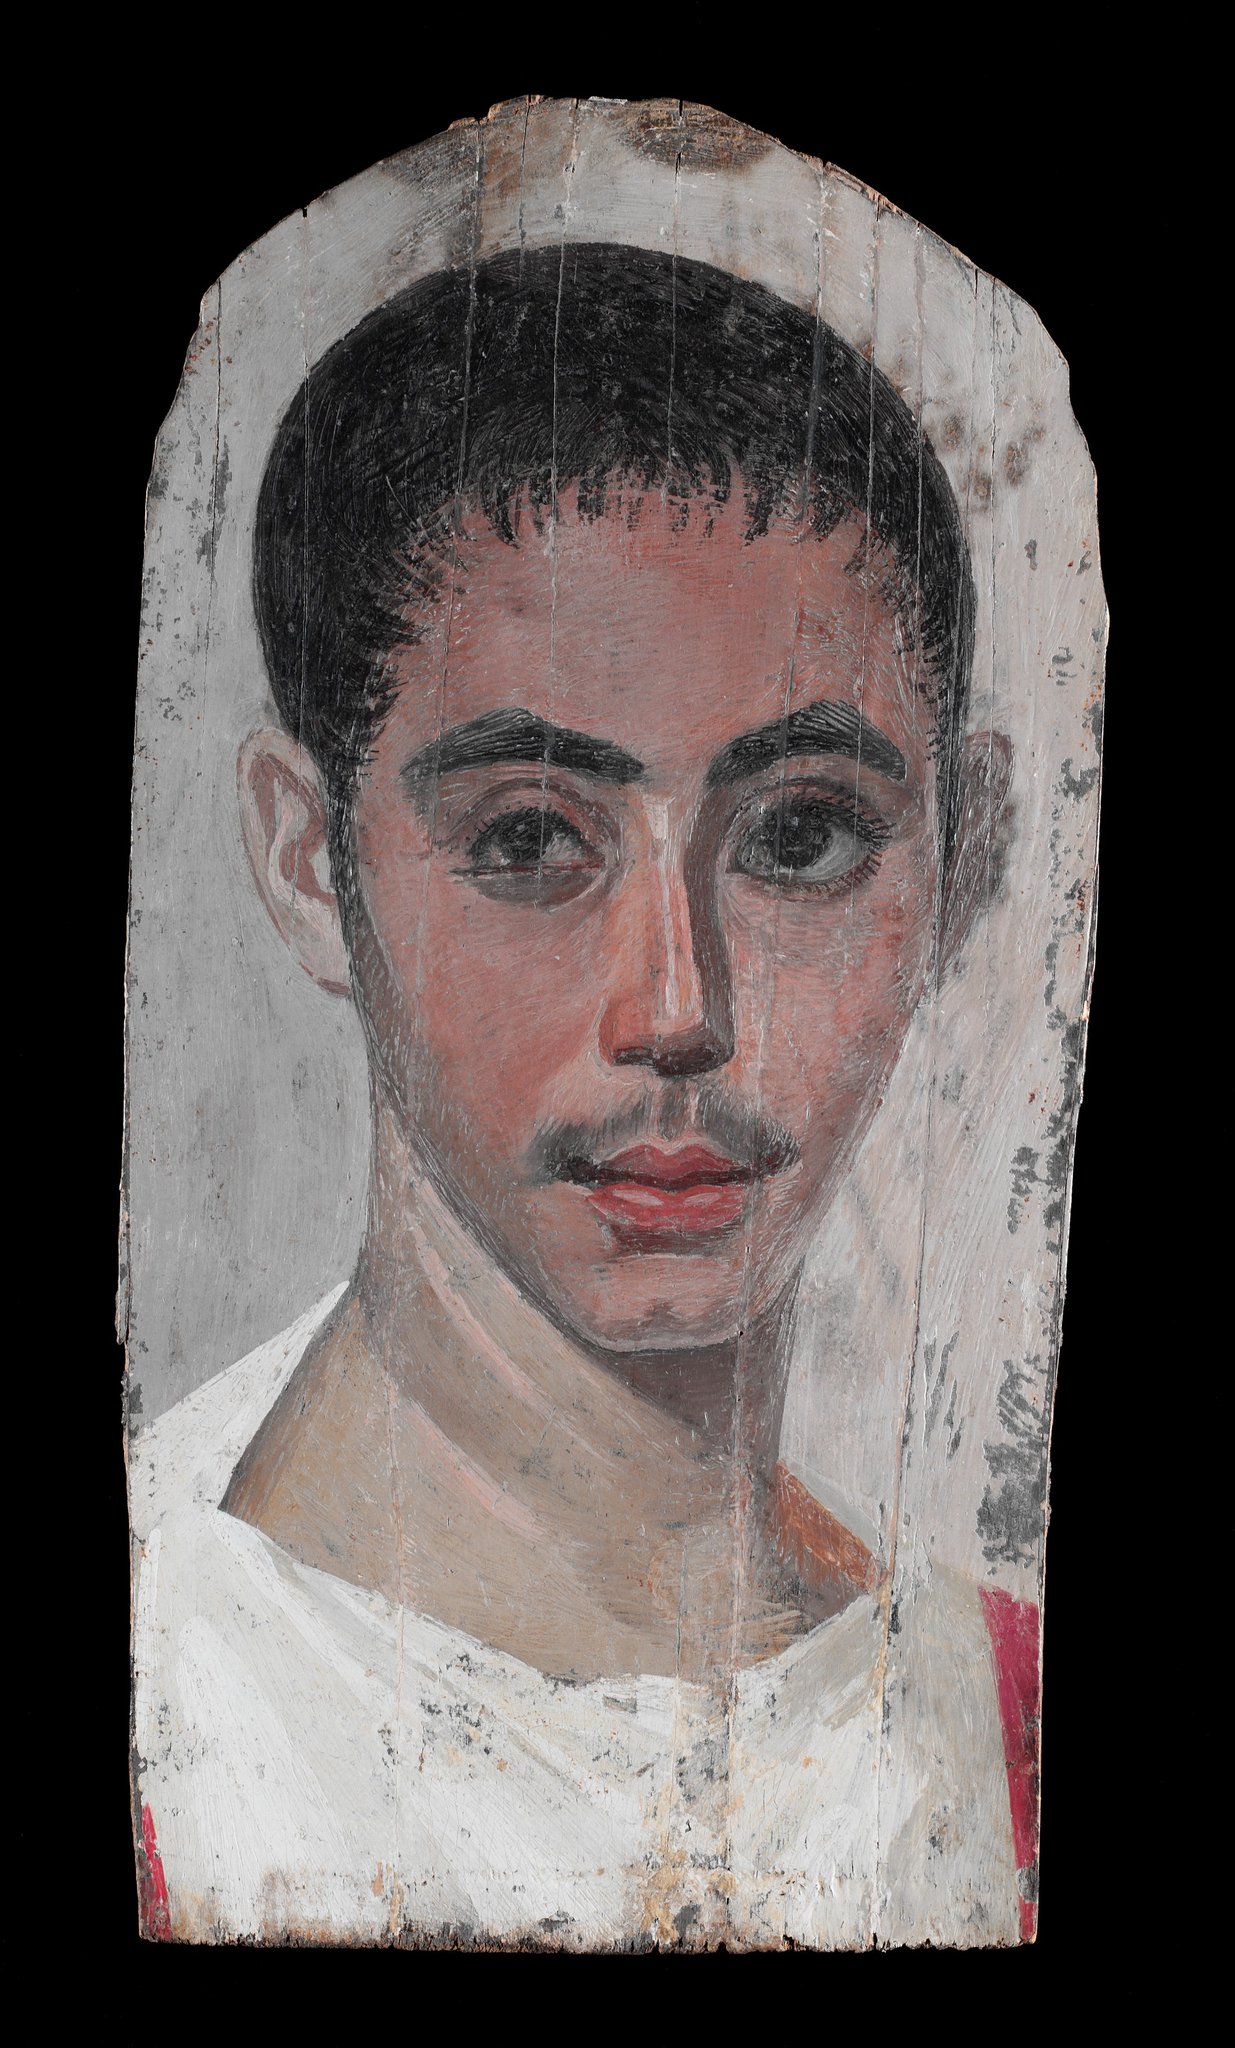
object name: panel painting, male with surgical cut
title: Portrait of a Youth with a Surgical Cut in one Eye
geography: egypt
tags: men,portraits